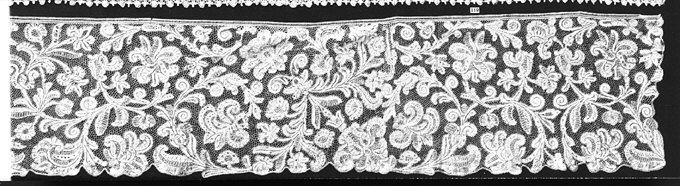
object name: fragment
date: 1601-1700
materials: lace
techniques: lace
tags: flowers,leaves